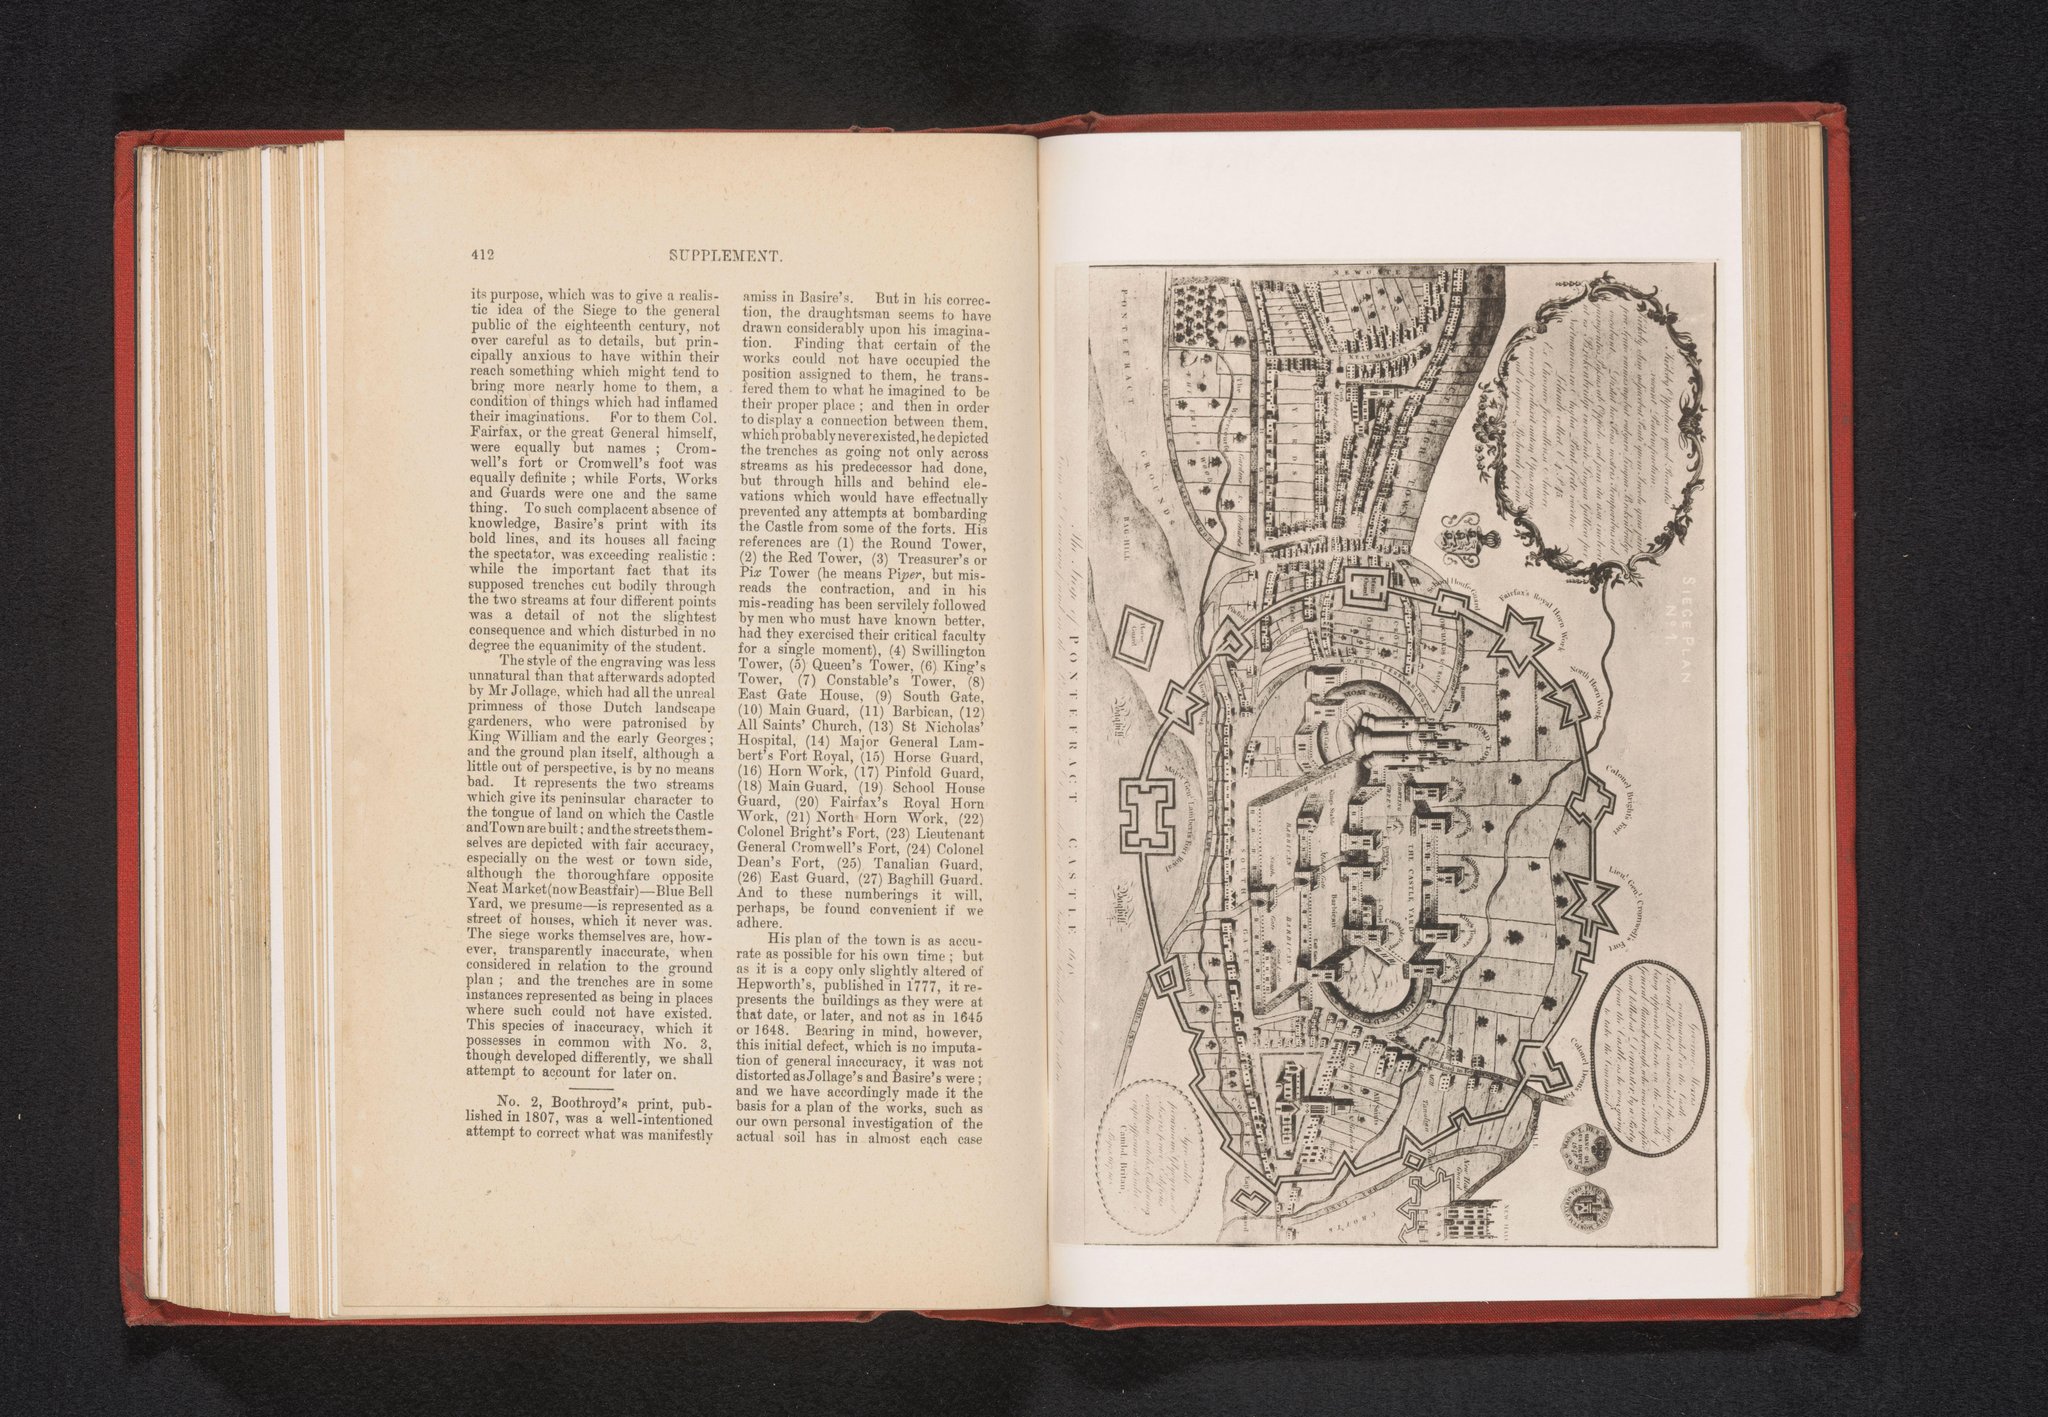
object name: reproduction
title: Reproductie van een prent van een belegeringsplan van het Beleg van Pontefract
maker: Anonymous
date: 1882-1887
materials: paper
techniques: photograph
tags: maps of cities, siege